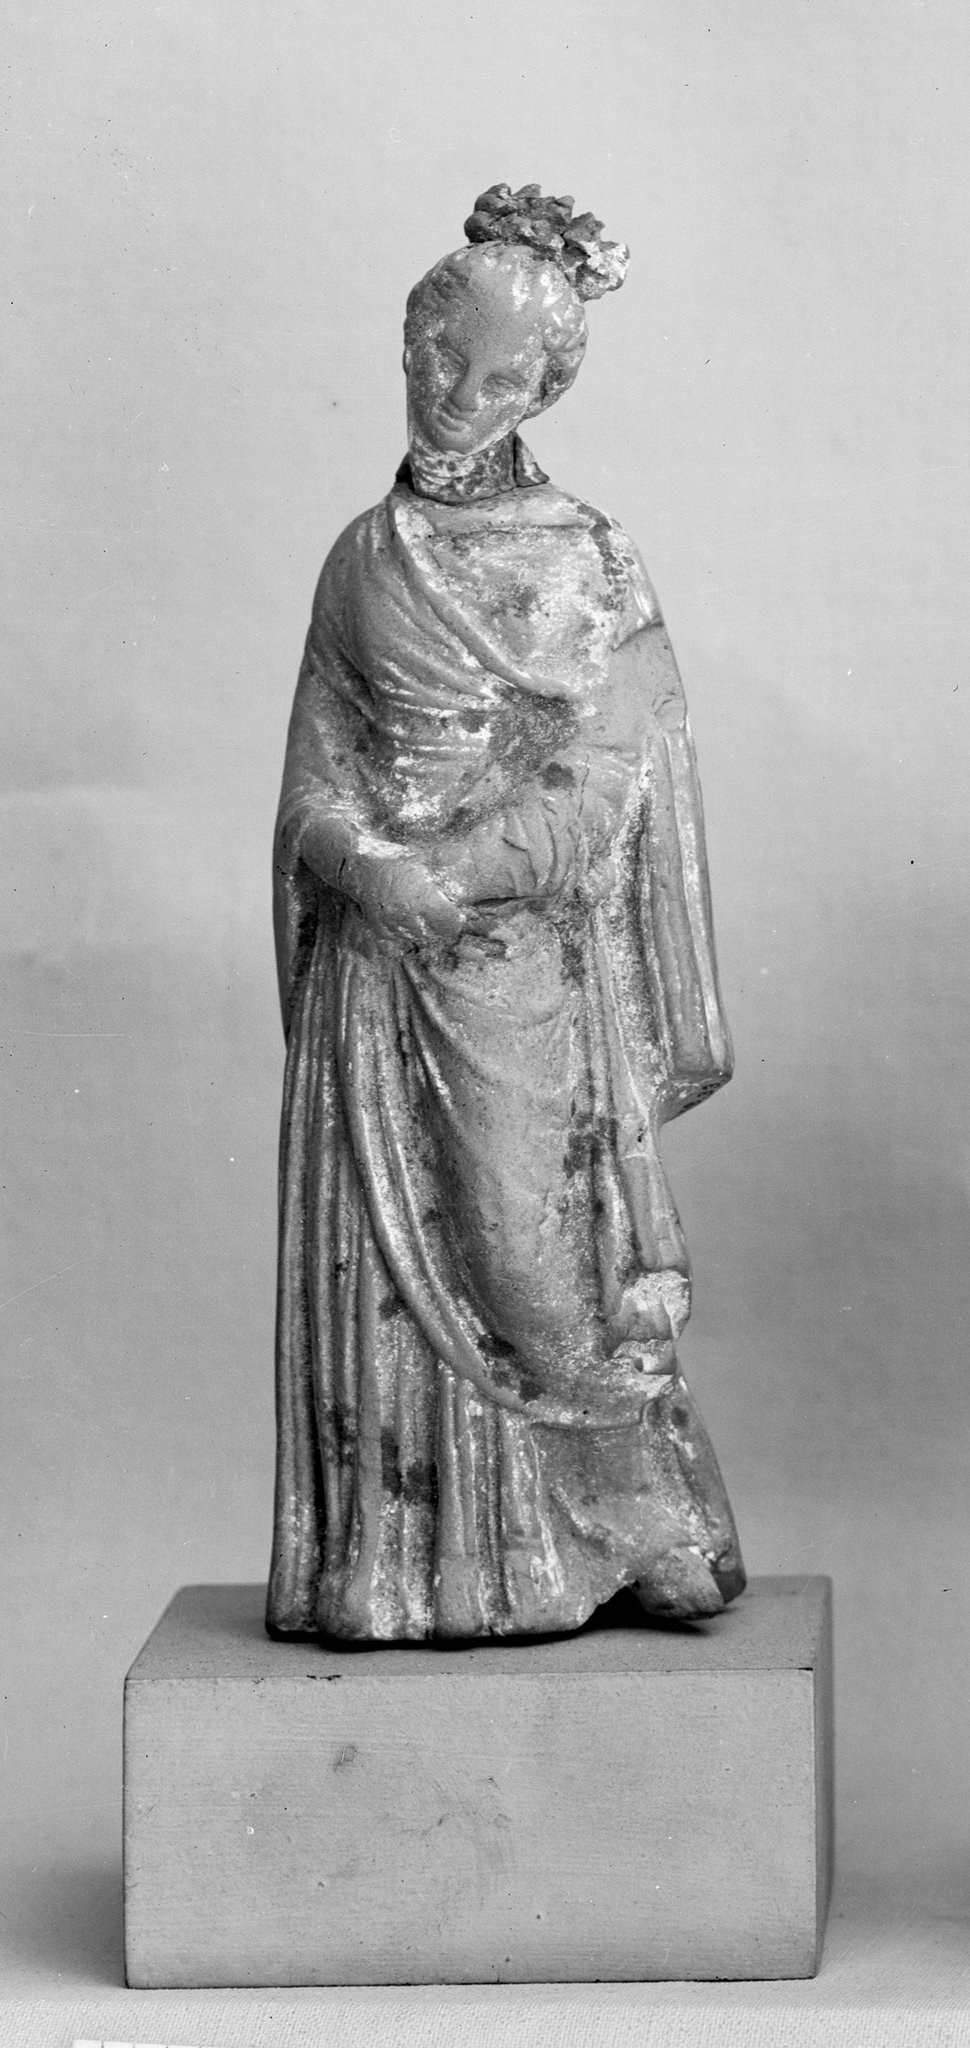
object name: statuette of a woman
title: Terracotta statuette of a woman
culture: greek, attic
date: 334-268 BCE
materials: terracotta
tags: women